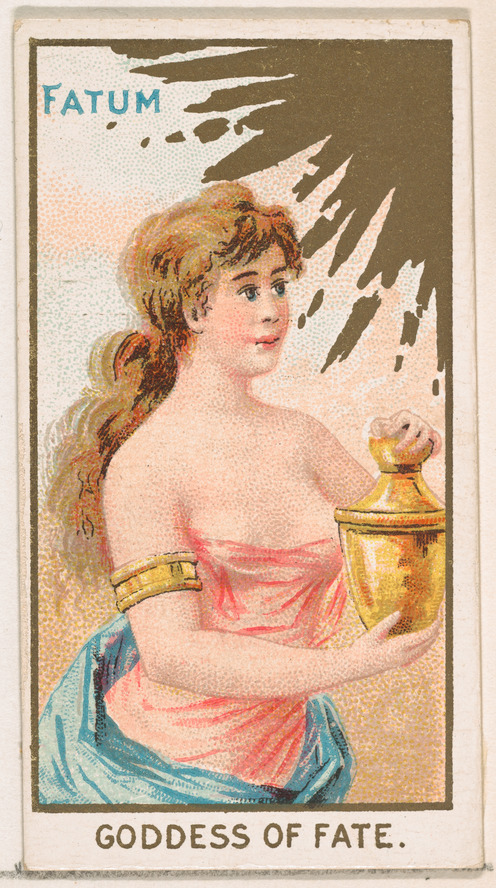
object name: print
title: Fatum, Goddess of Fate, from the Goddesses of the Greeks and Romans series (N188) issued by Wm. S. Kimball & Co.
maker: william s. kimball & company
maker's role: publisher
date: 1889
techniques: color lithograph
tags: goddess